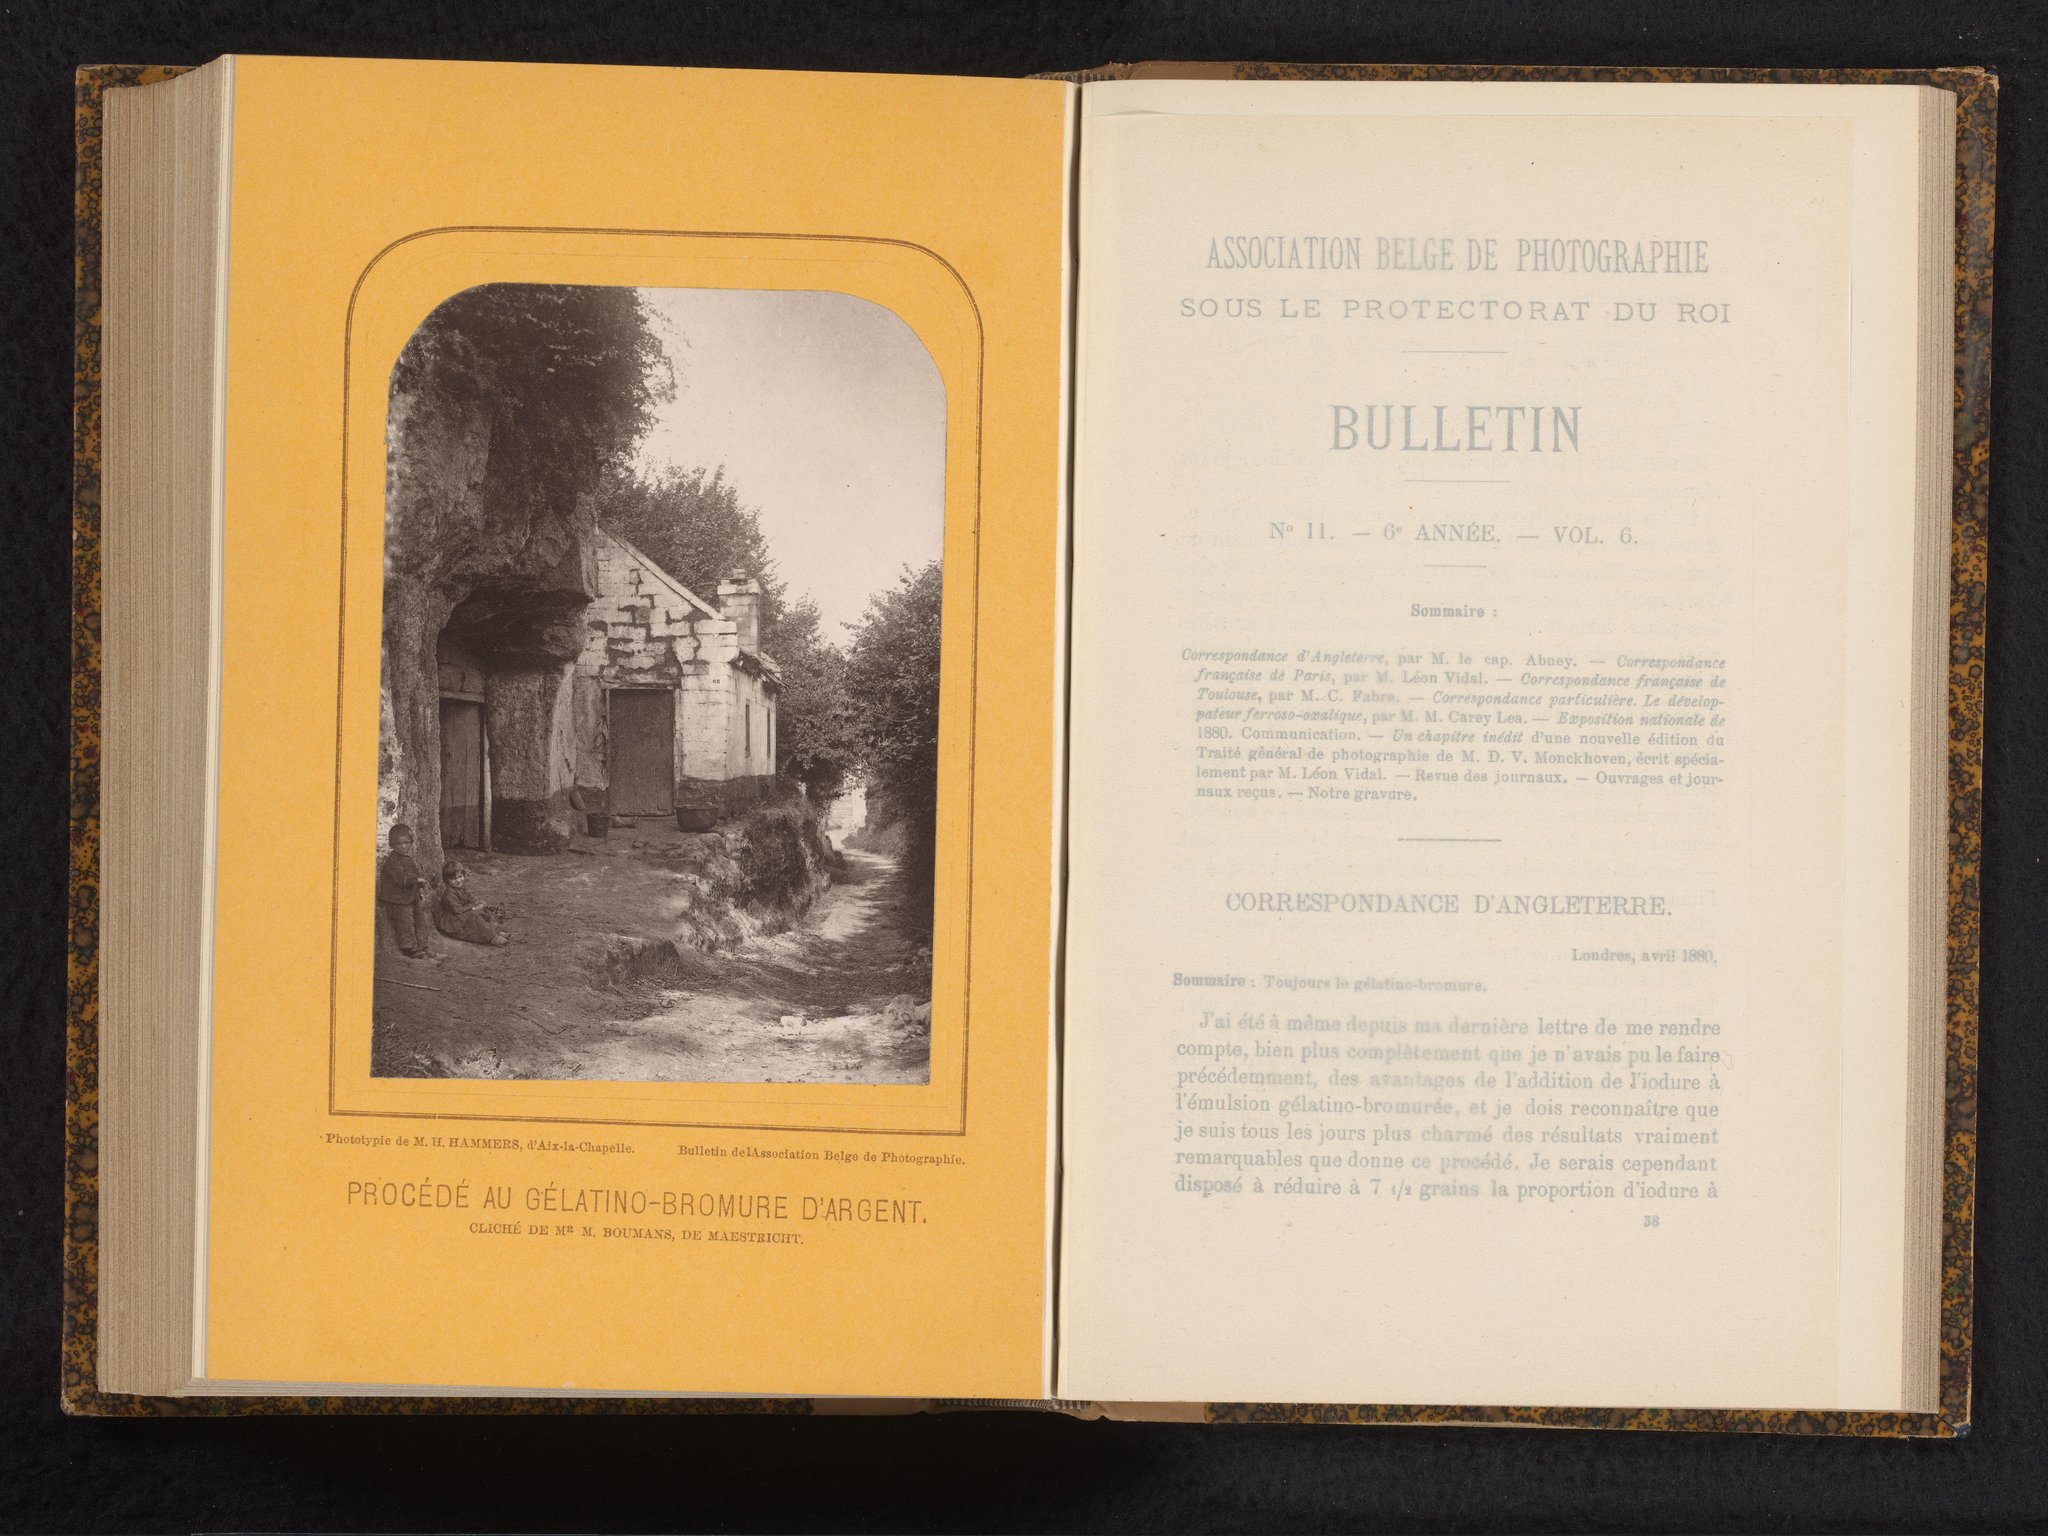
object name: photomechanical print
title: Rotswoningen in Limburg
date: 1875-1880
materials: cardboard, paper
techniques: photograph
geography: limburg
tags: cottage, cave, grotto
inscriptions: inscription: ‘Procédé au gélatino-bromure d'argent’